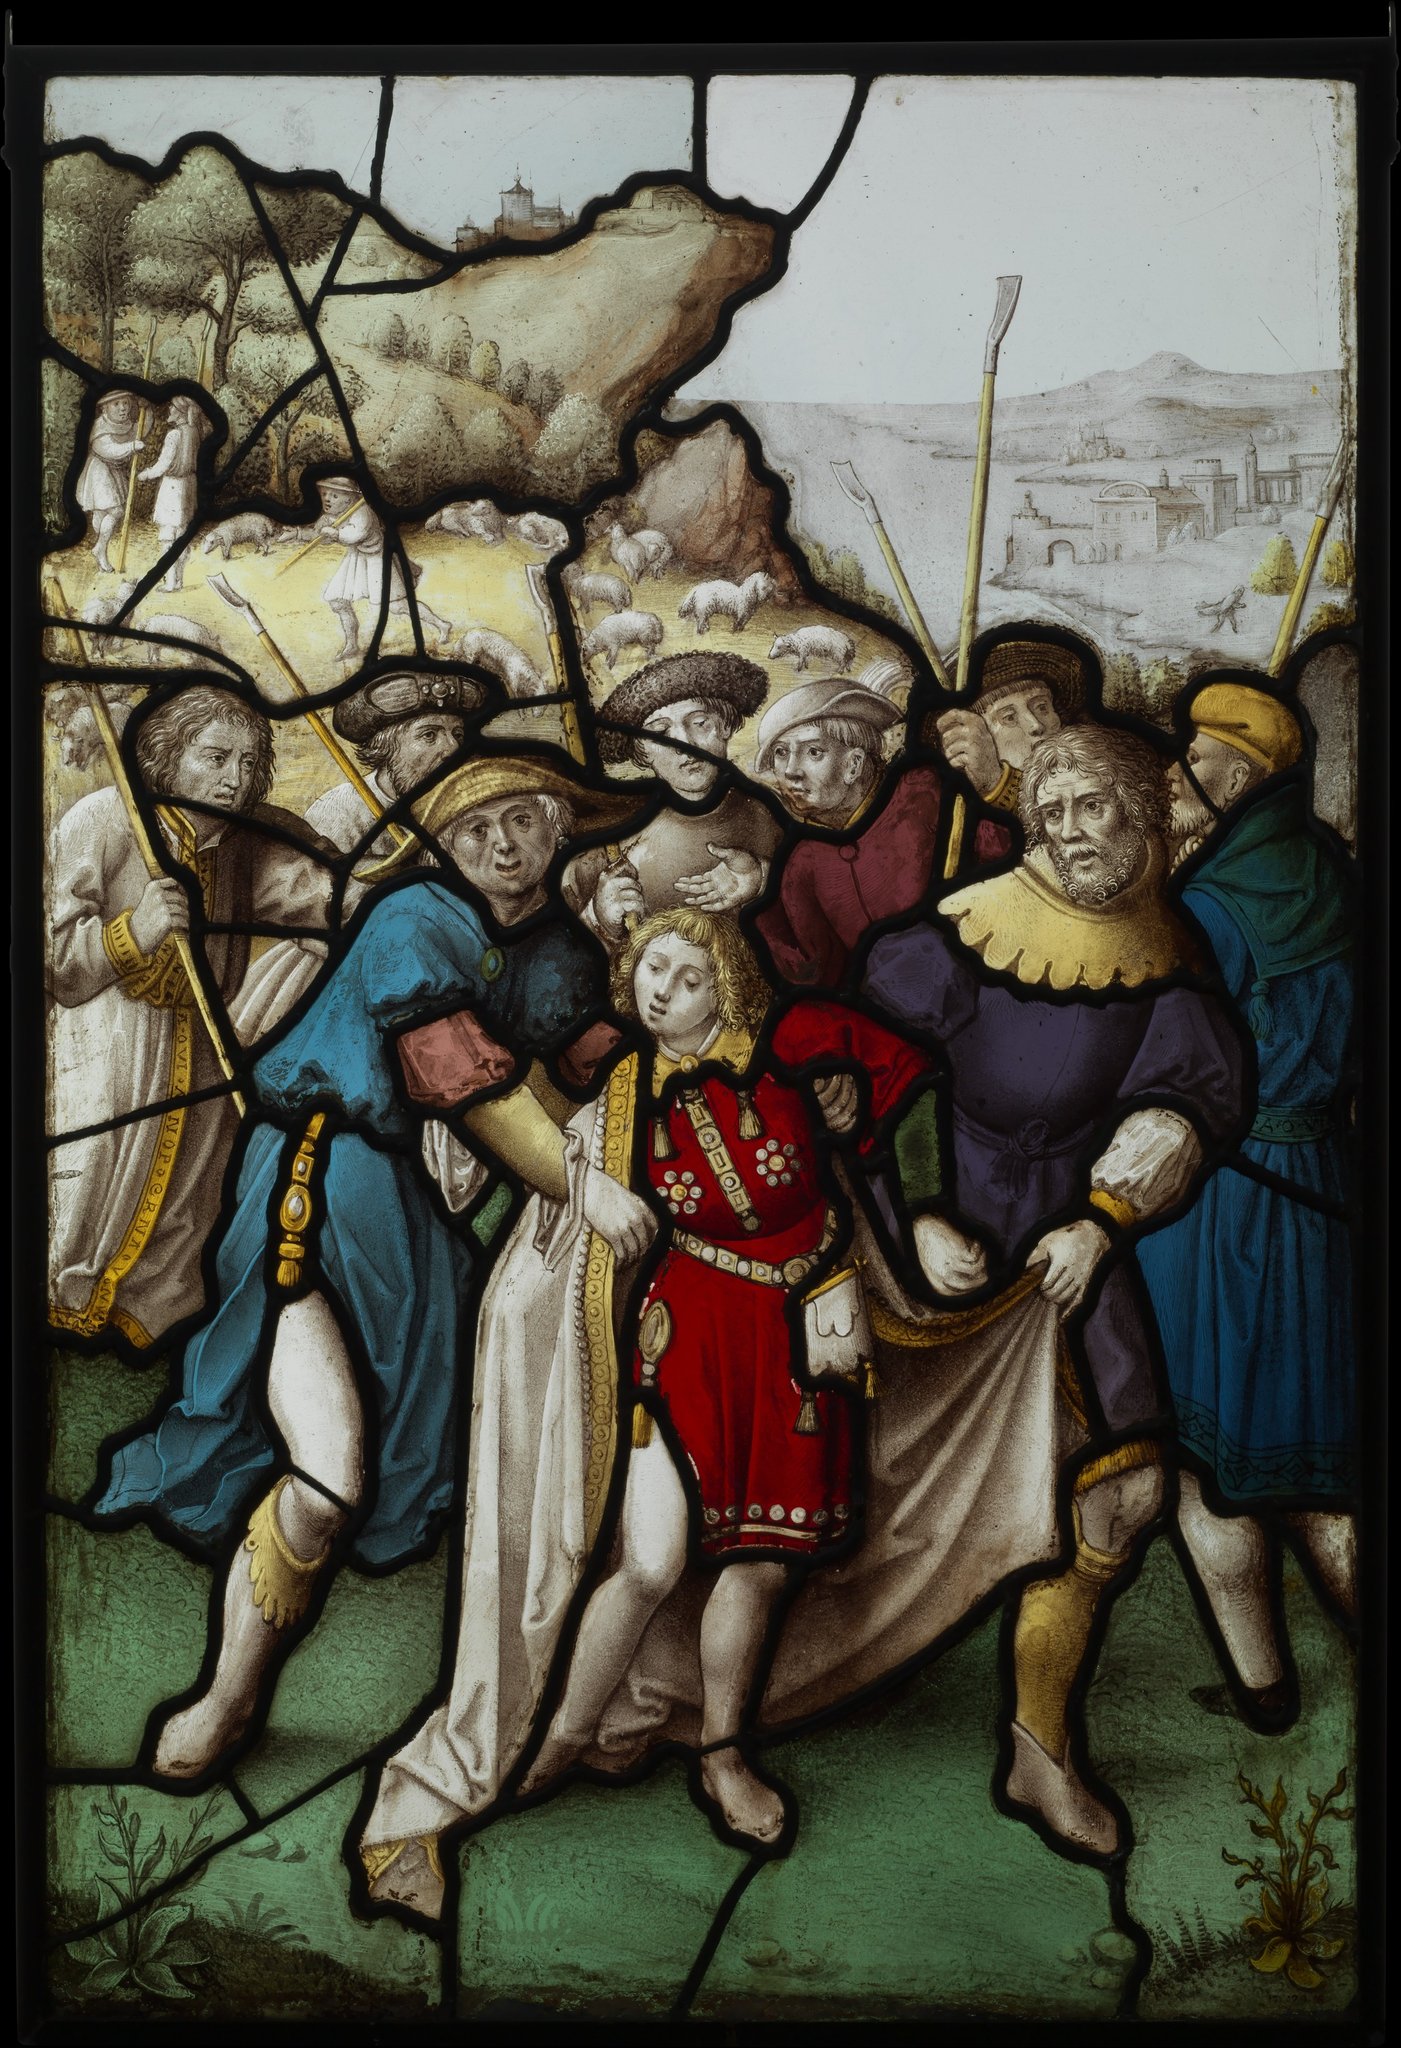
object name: panel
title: Joseph Being Stripped of His Cloak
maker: jan rombouts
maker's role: maker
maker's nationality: south netherlandish (duchy of brabant)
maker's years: 1475-1535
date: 1520-1525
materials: glass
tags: animals,men